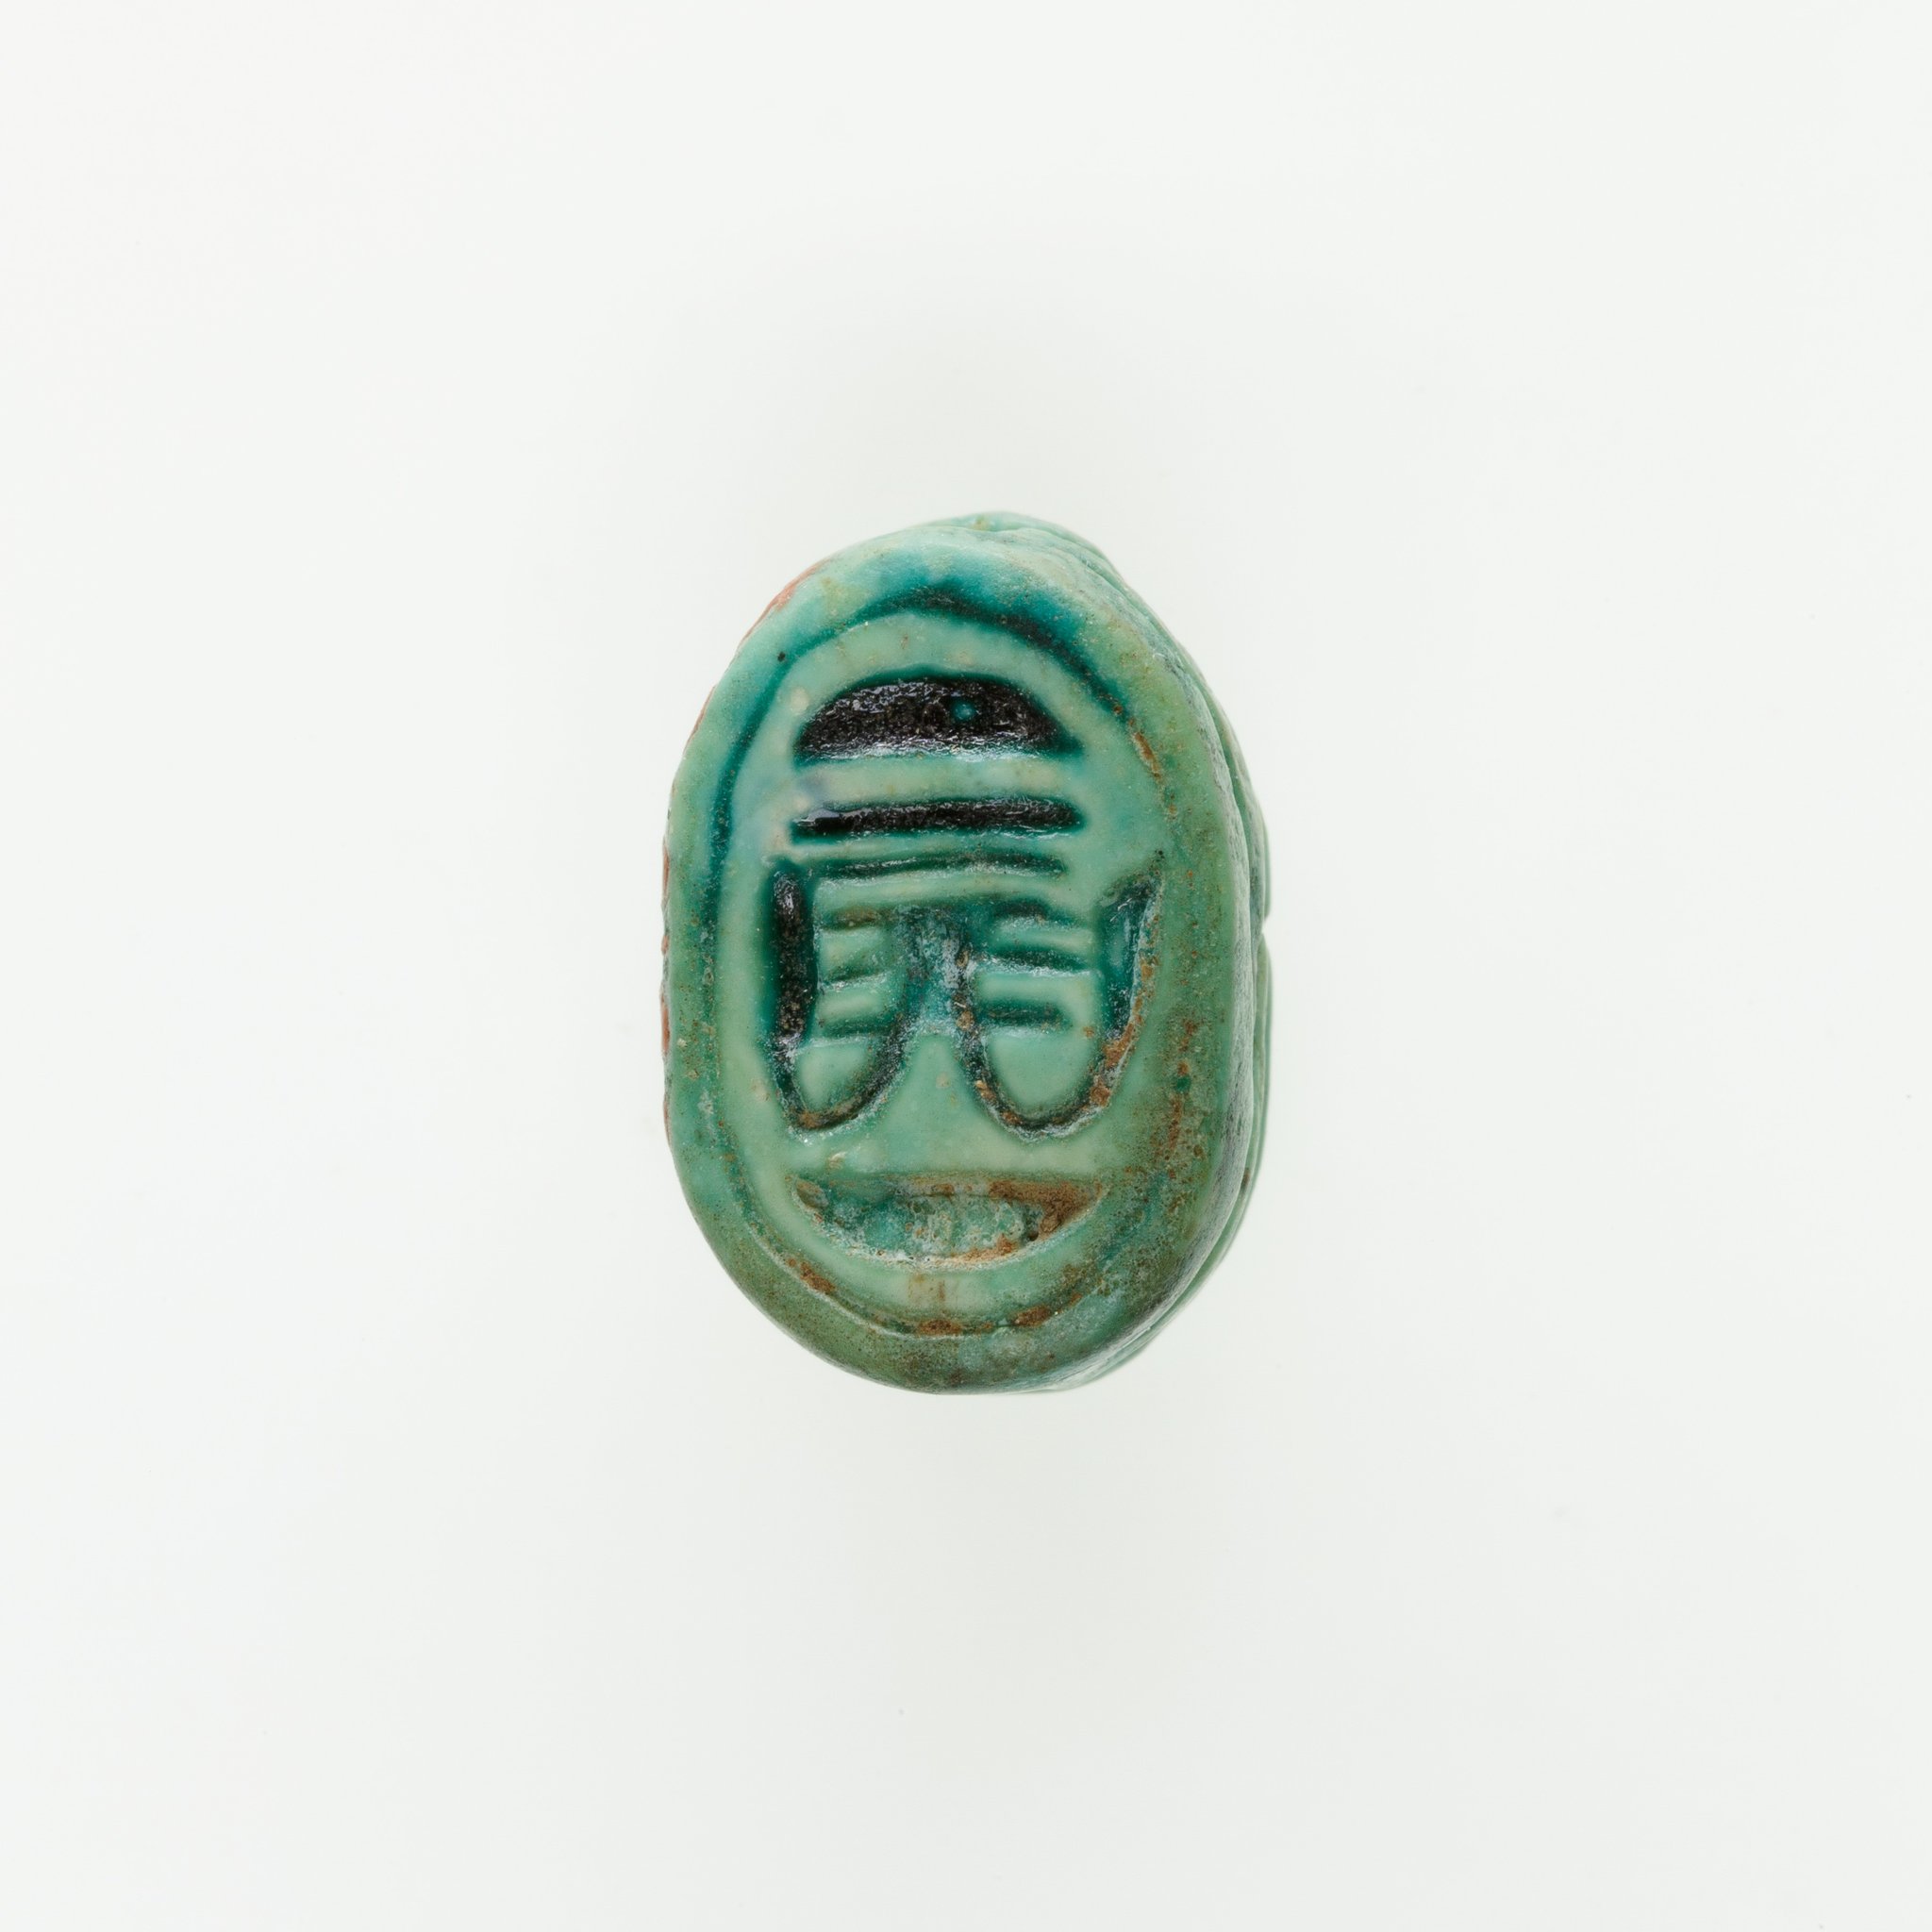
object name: scarab, djed pillar, cobra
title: Scarabs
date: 1492-1473 BCE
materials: stone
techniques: glazing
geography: egypt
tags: scarabs